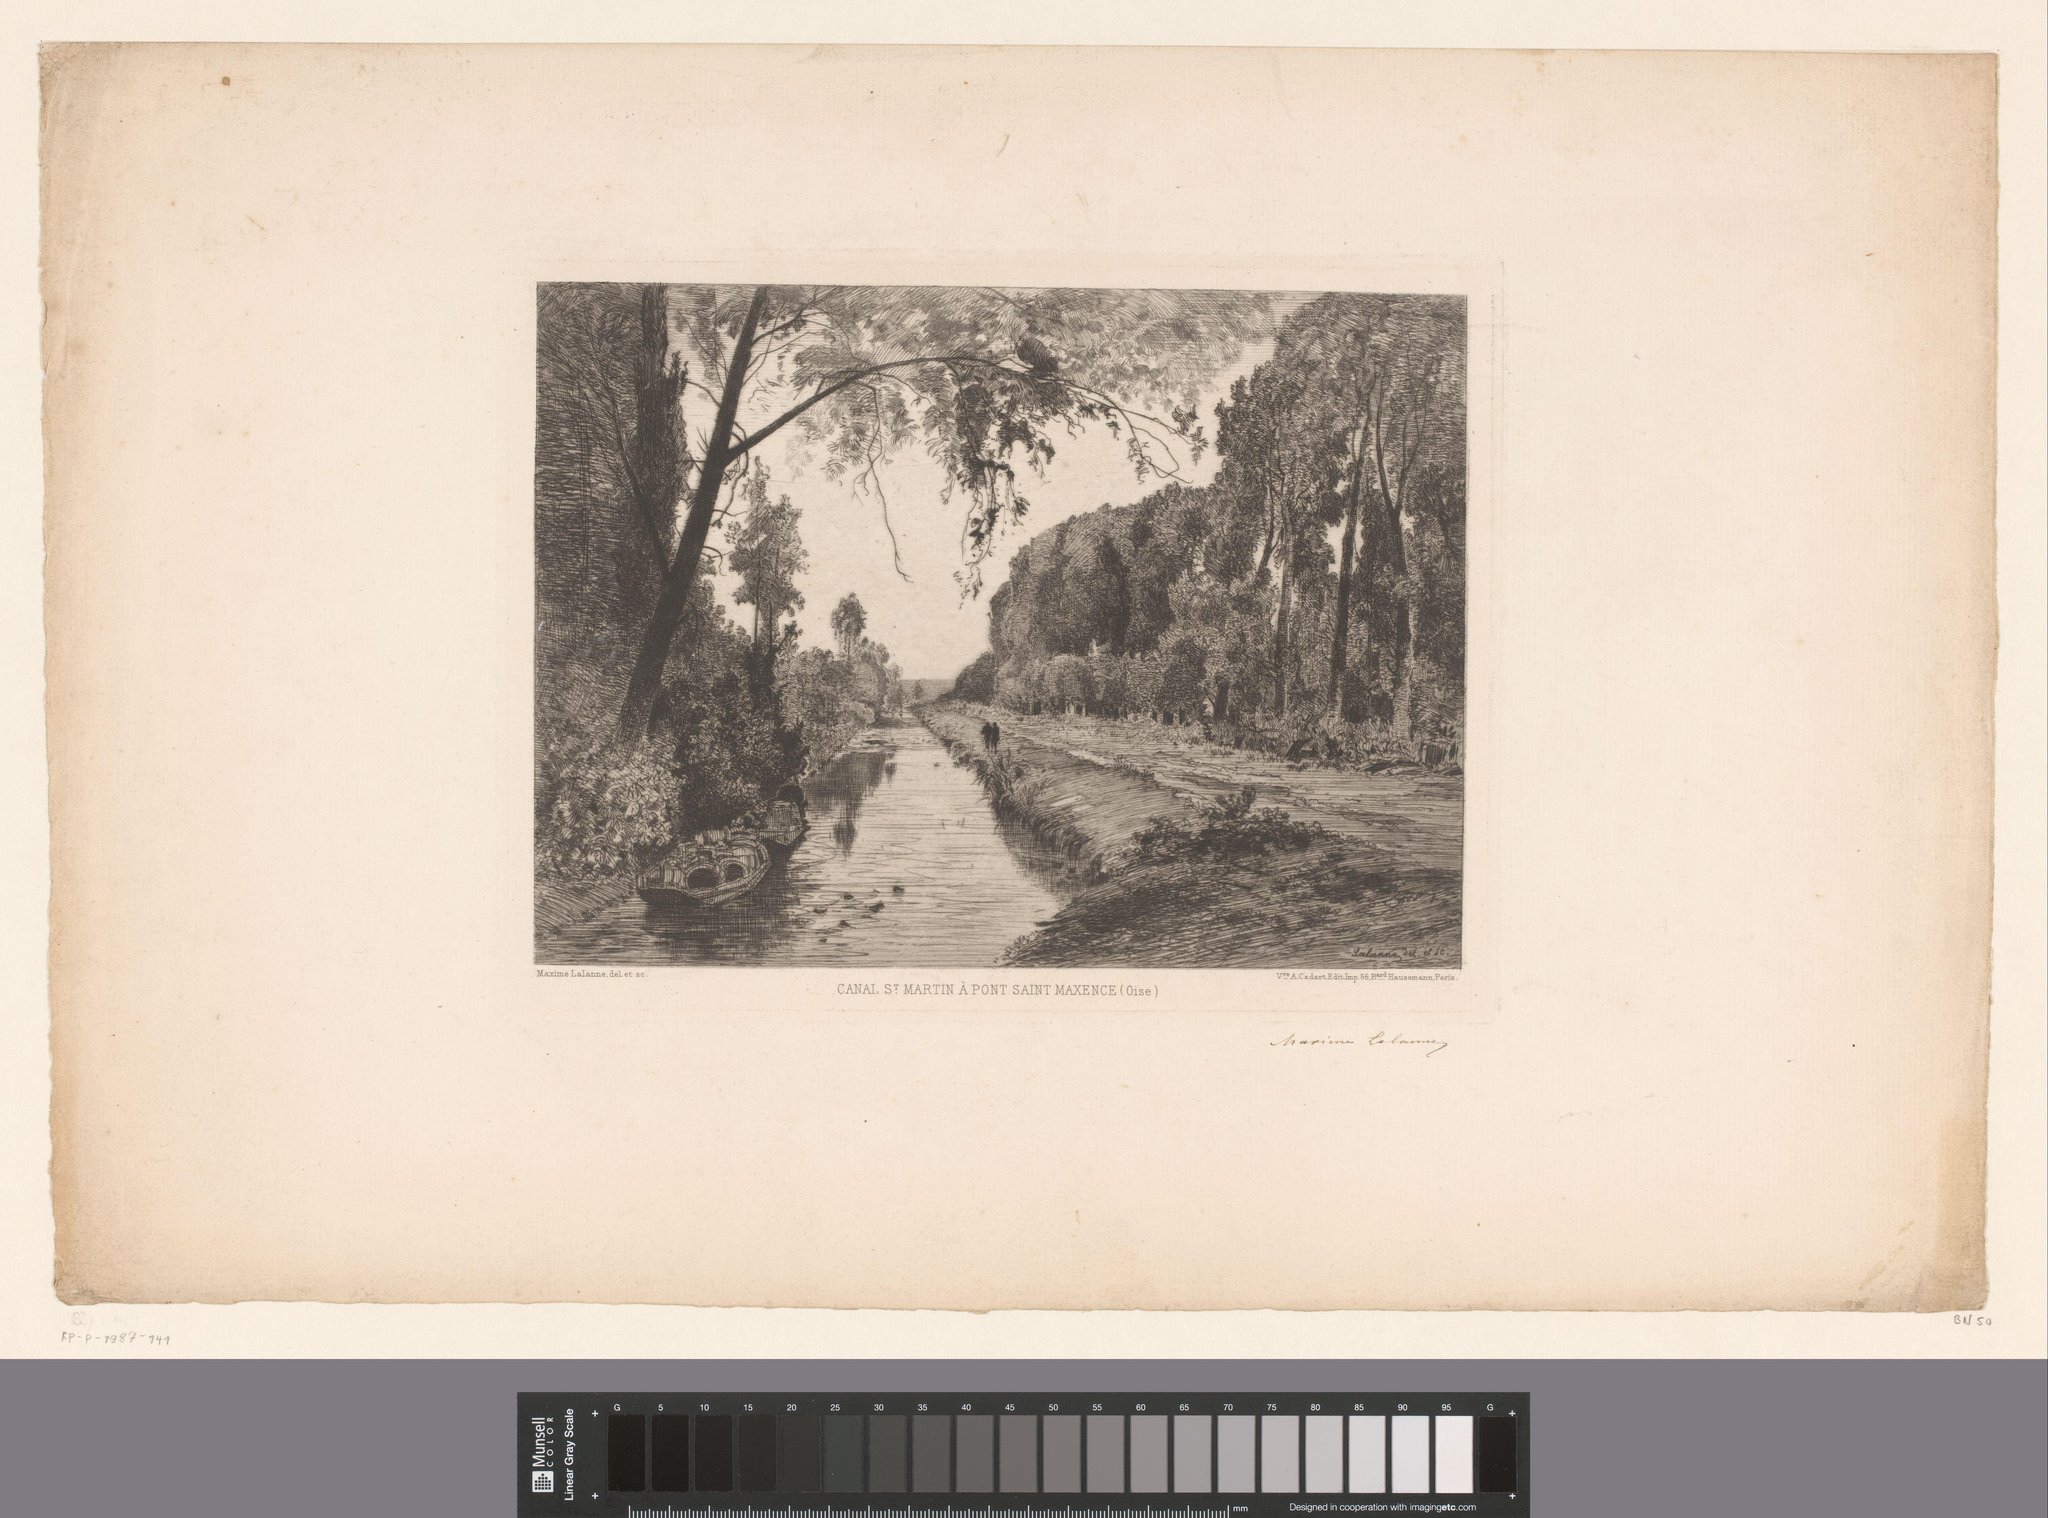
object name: print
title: Landschap met het Canal Saint-Martin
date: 1876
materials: paper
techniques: drypoint, engraving, etching, intaglio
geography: paris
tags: river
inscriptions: watermark, collector's mark: Lugt 2228